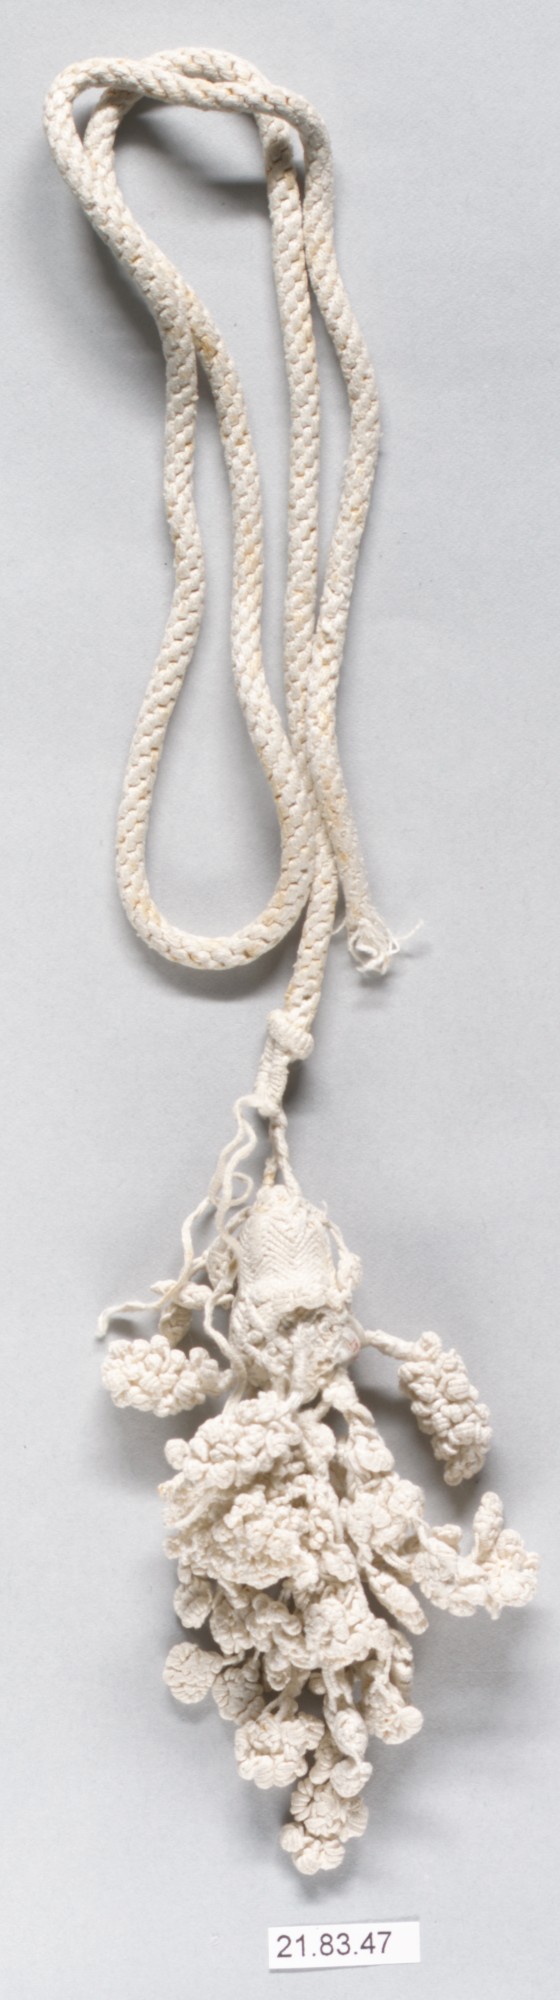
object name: tassel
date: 1601-1700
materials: linen